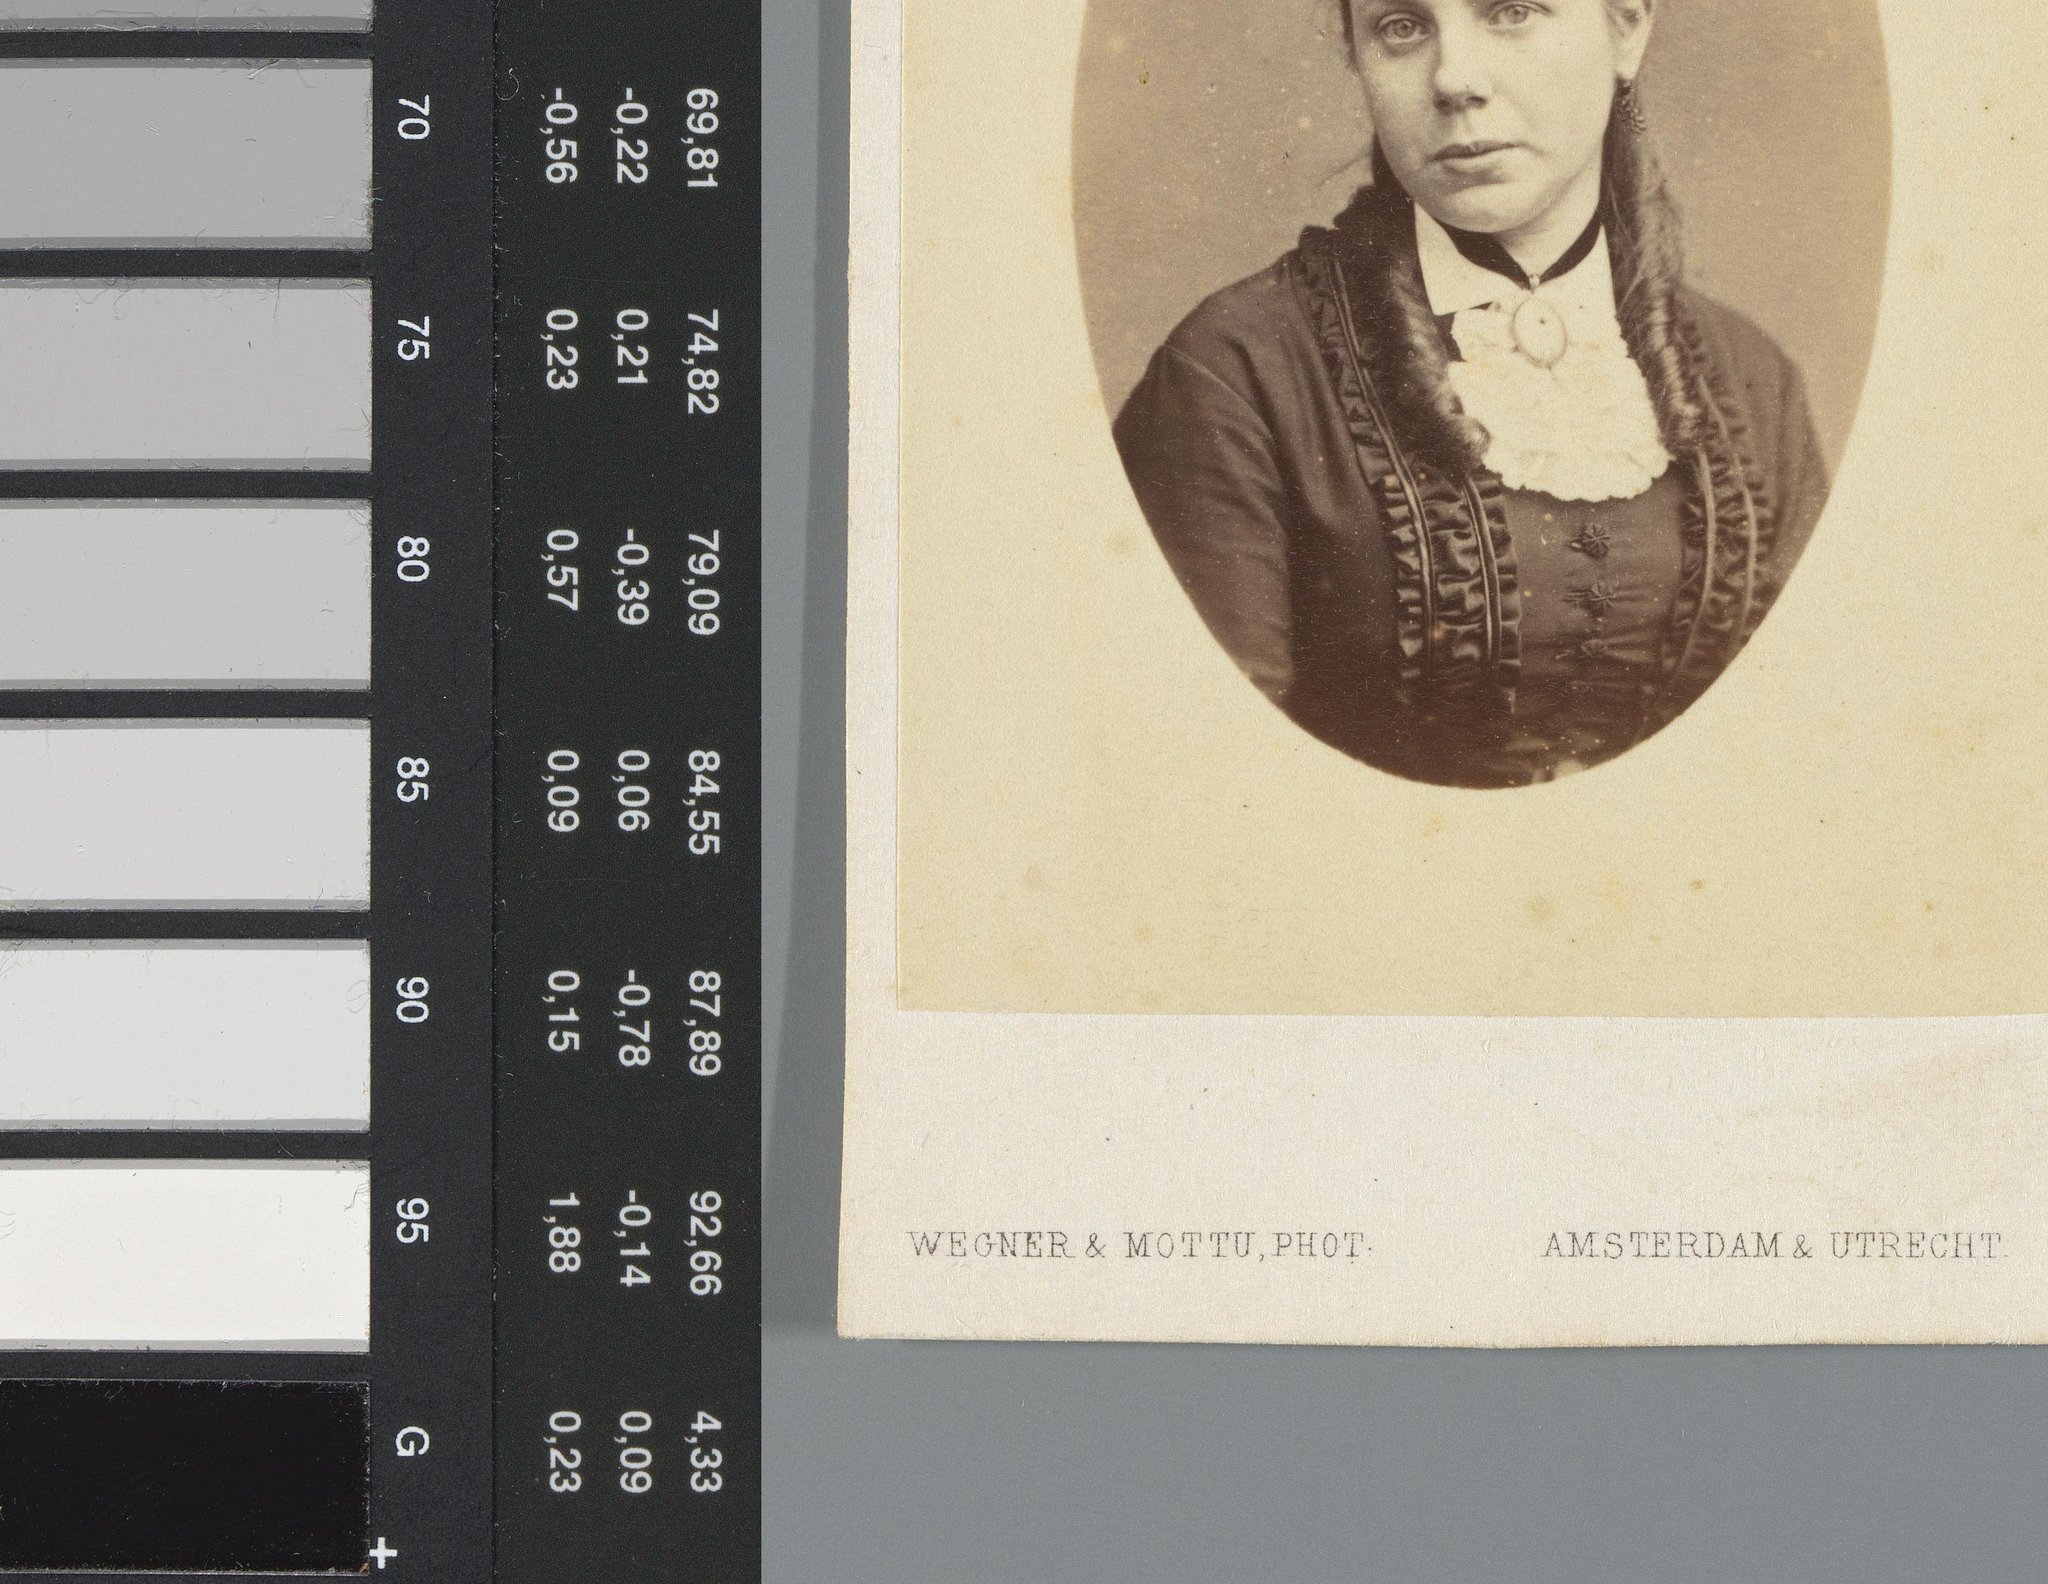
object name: carte de visite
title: Portret van Carolina Frederika Holle in ovaal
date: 1855-1870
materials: cardboard, photographic support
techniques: albumen print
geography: netherlands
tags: amsterdam, carolina frederika van den berg-holle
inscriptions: name: ‘WEGNER & MOTTU, PHOT. AMSTERDAM & UTRECHT’, name, name: ‘C.F. van den Berg - Holle’